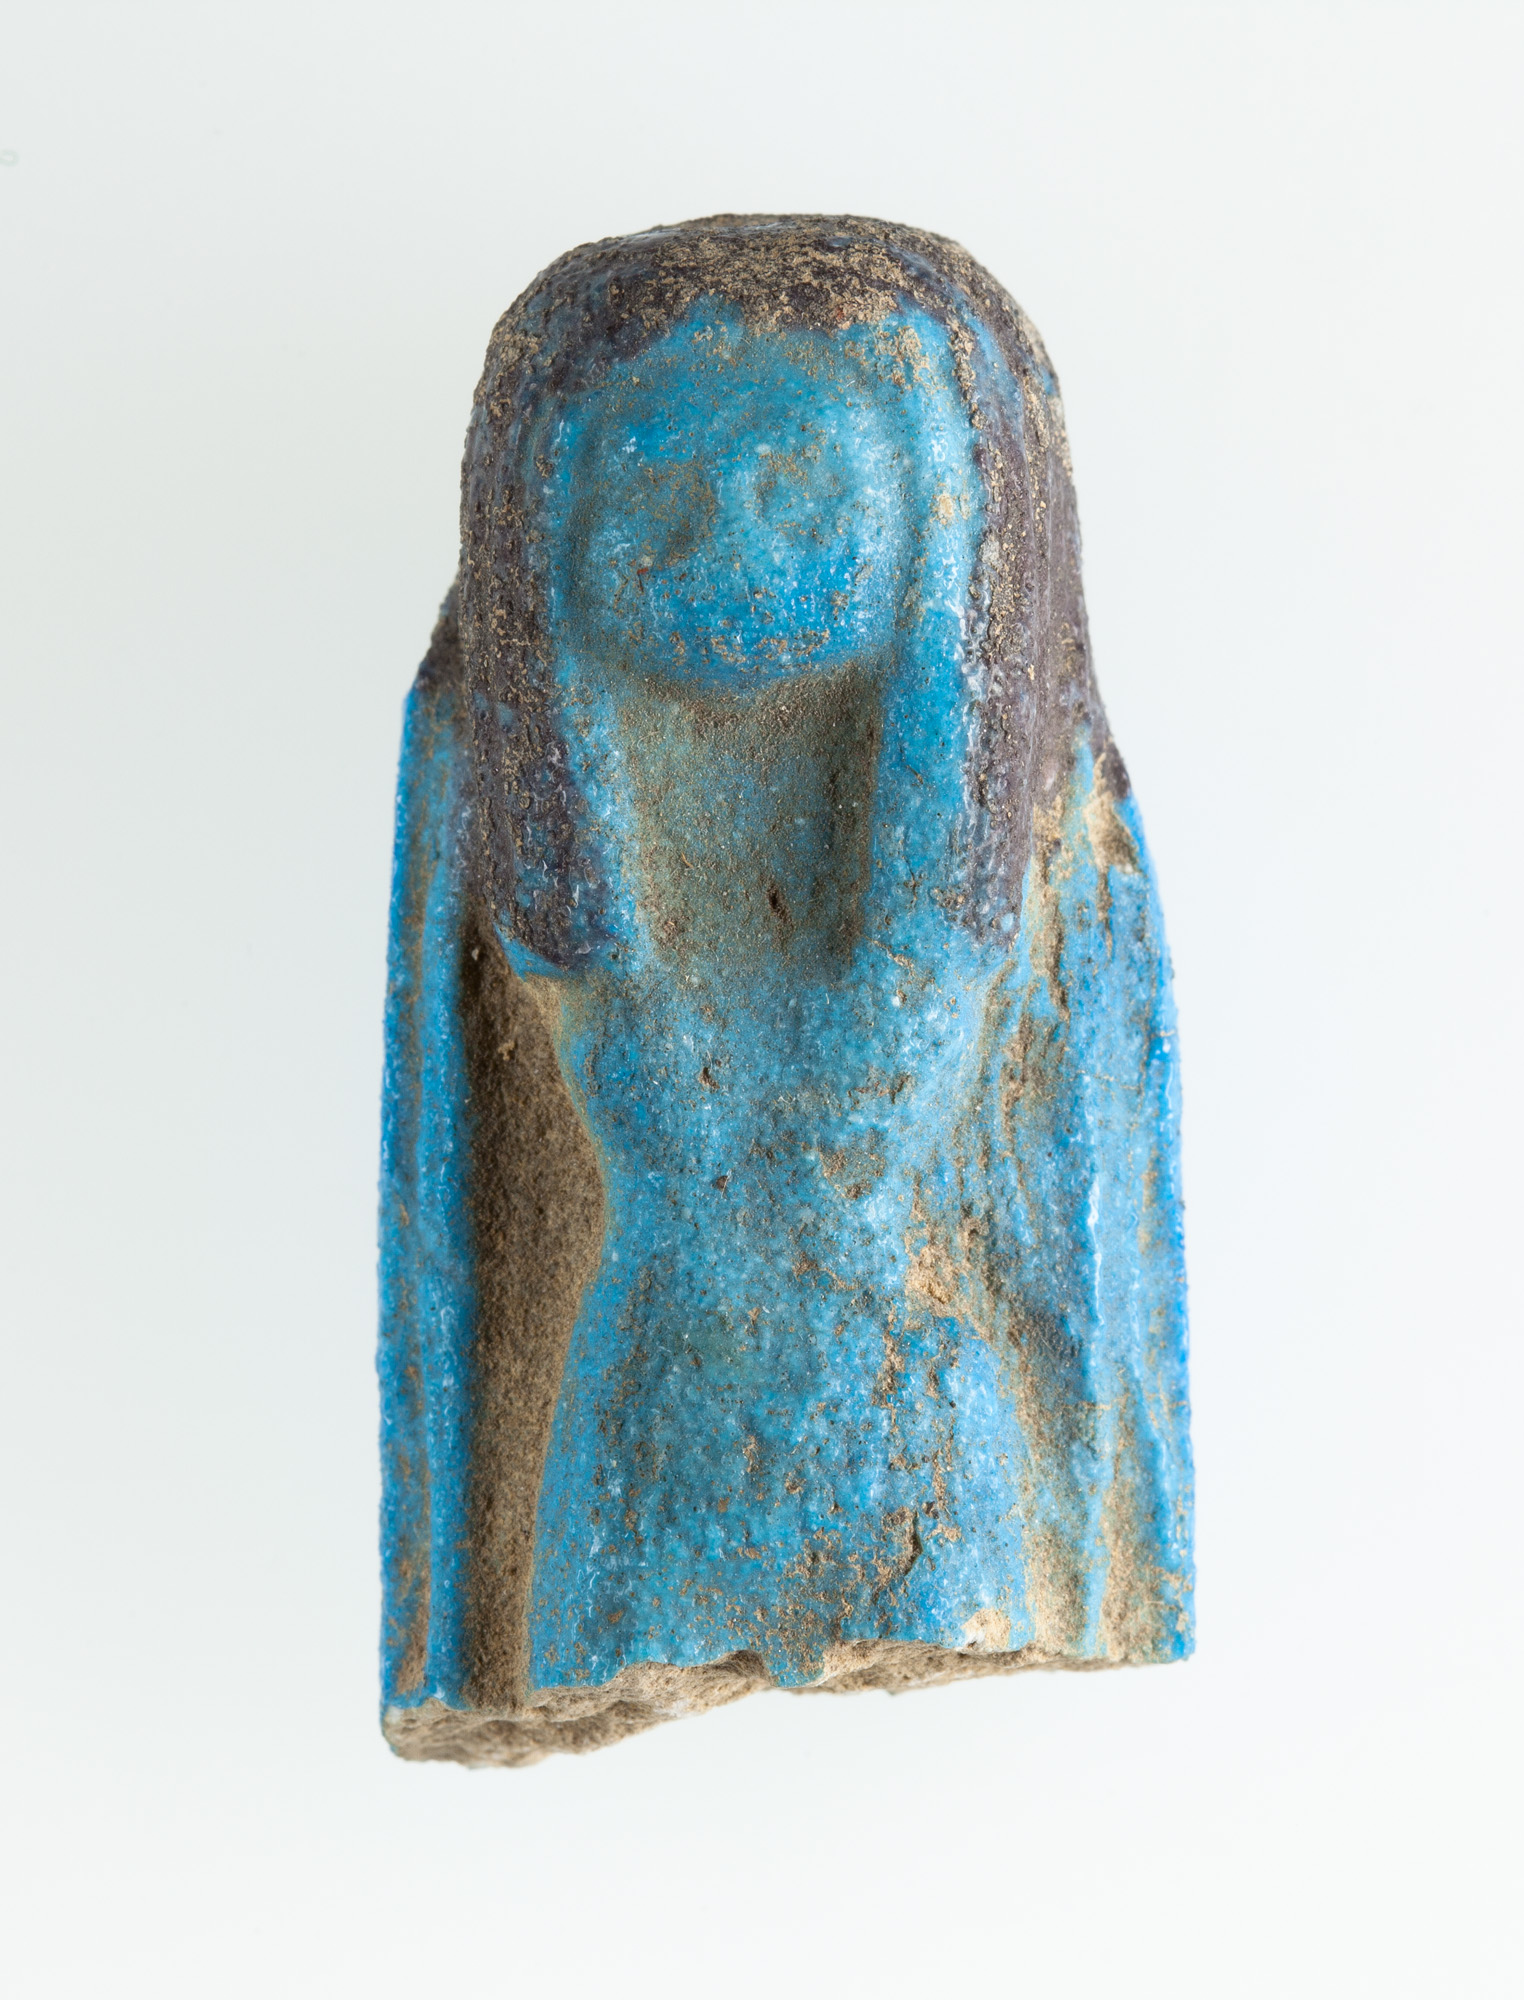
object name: votive, female figure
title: Female Votive Figure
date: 1479-1458 BCE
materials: faience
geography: egypt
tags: women